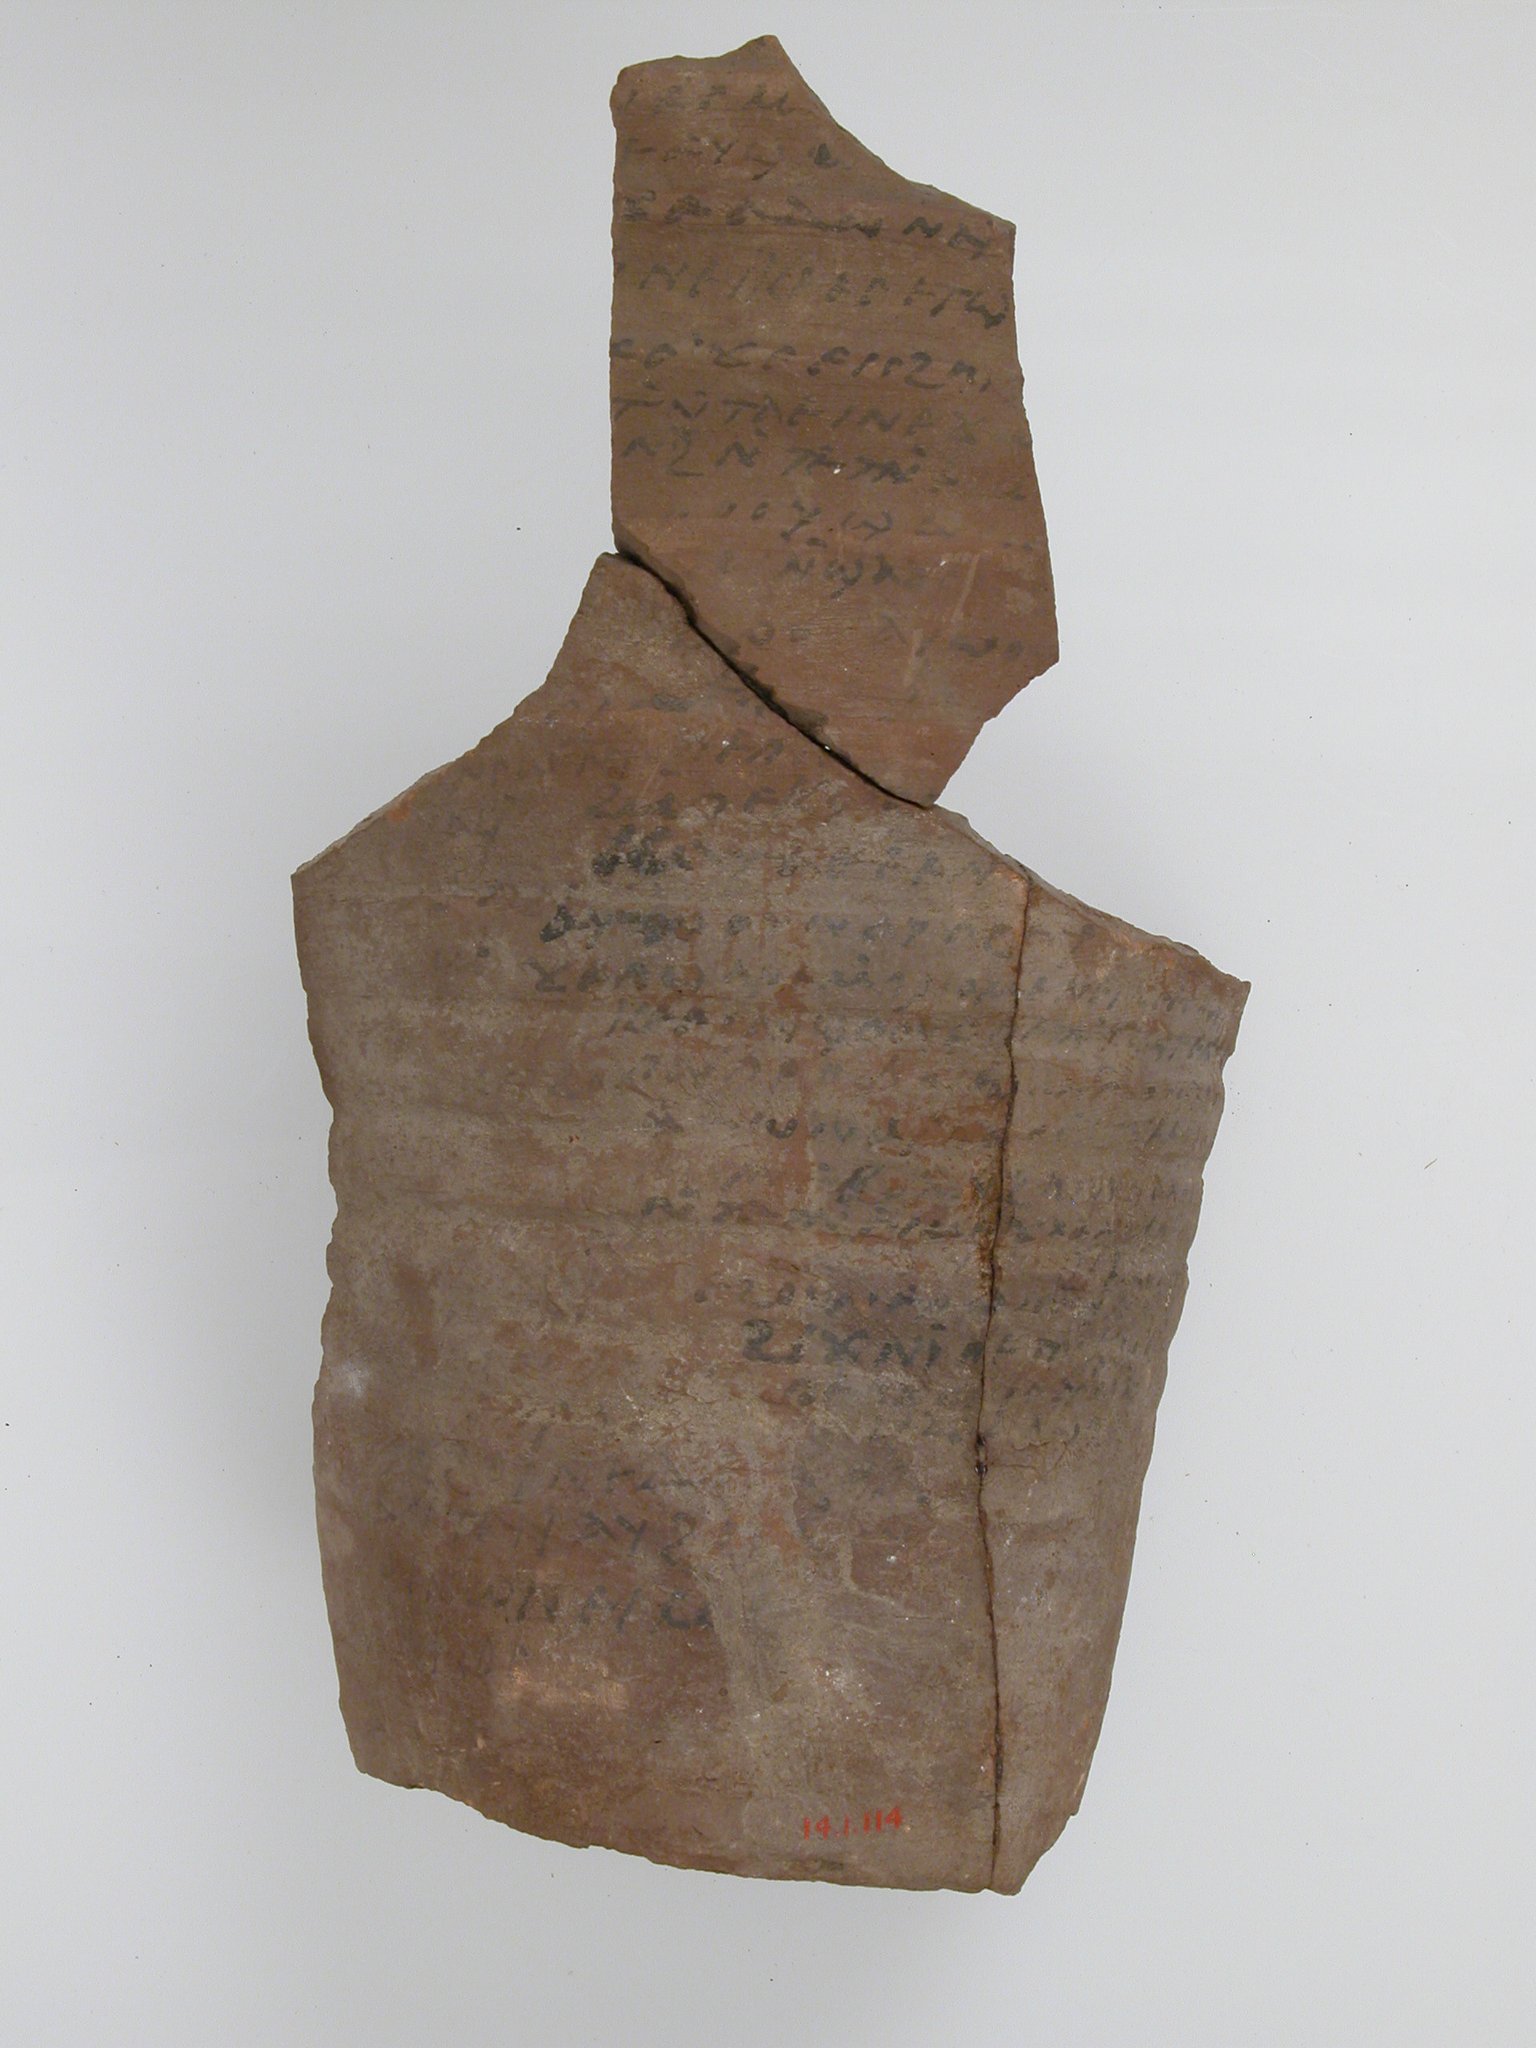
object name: ostrakon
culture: coptic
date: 600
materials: ink, pottery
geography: egypt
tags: coptic,documents